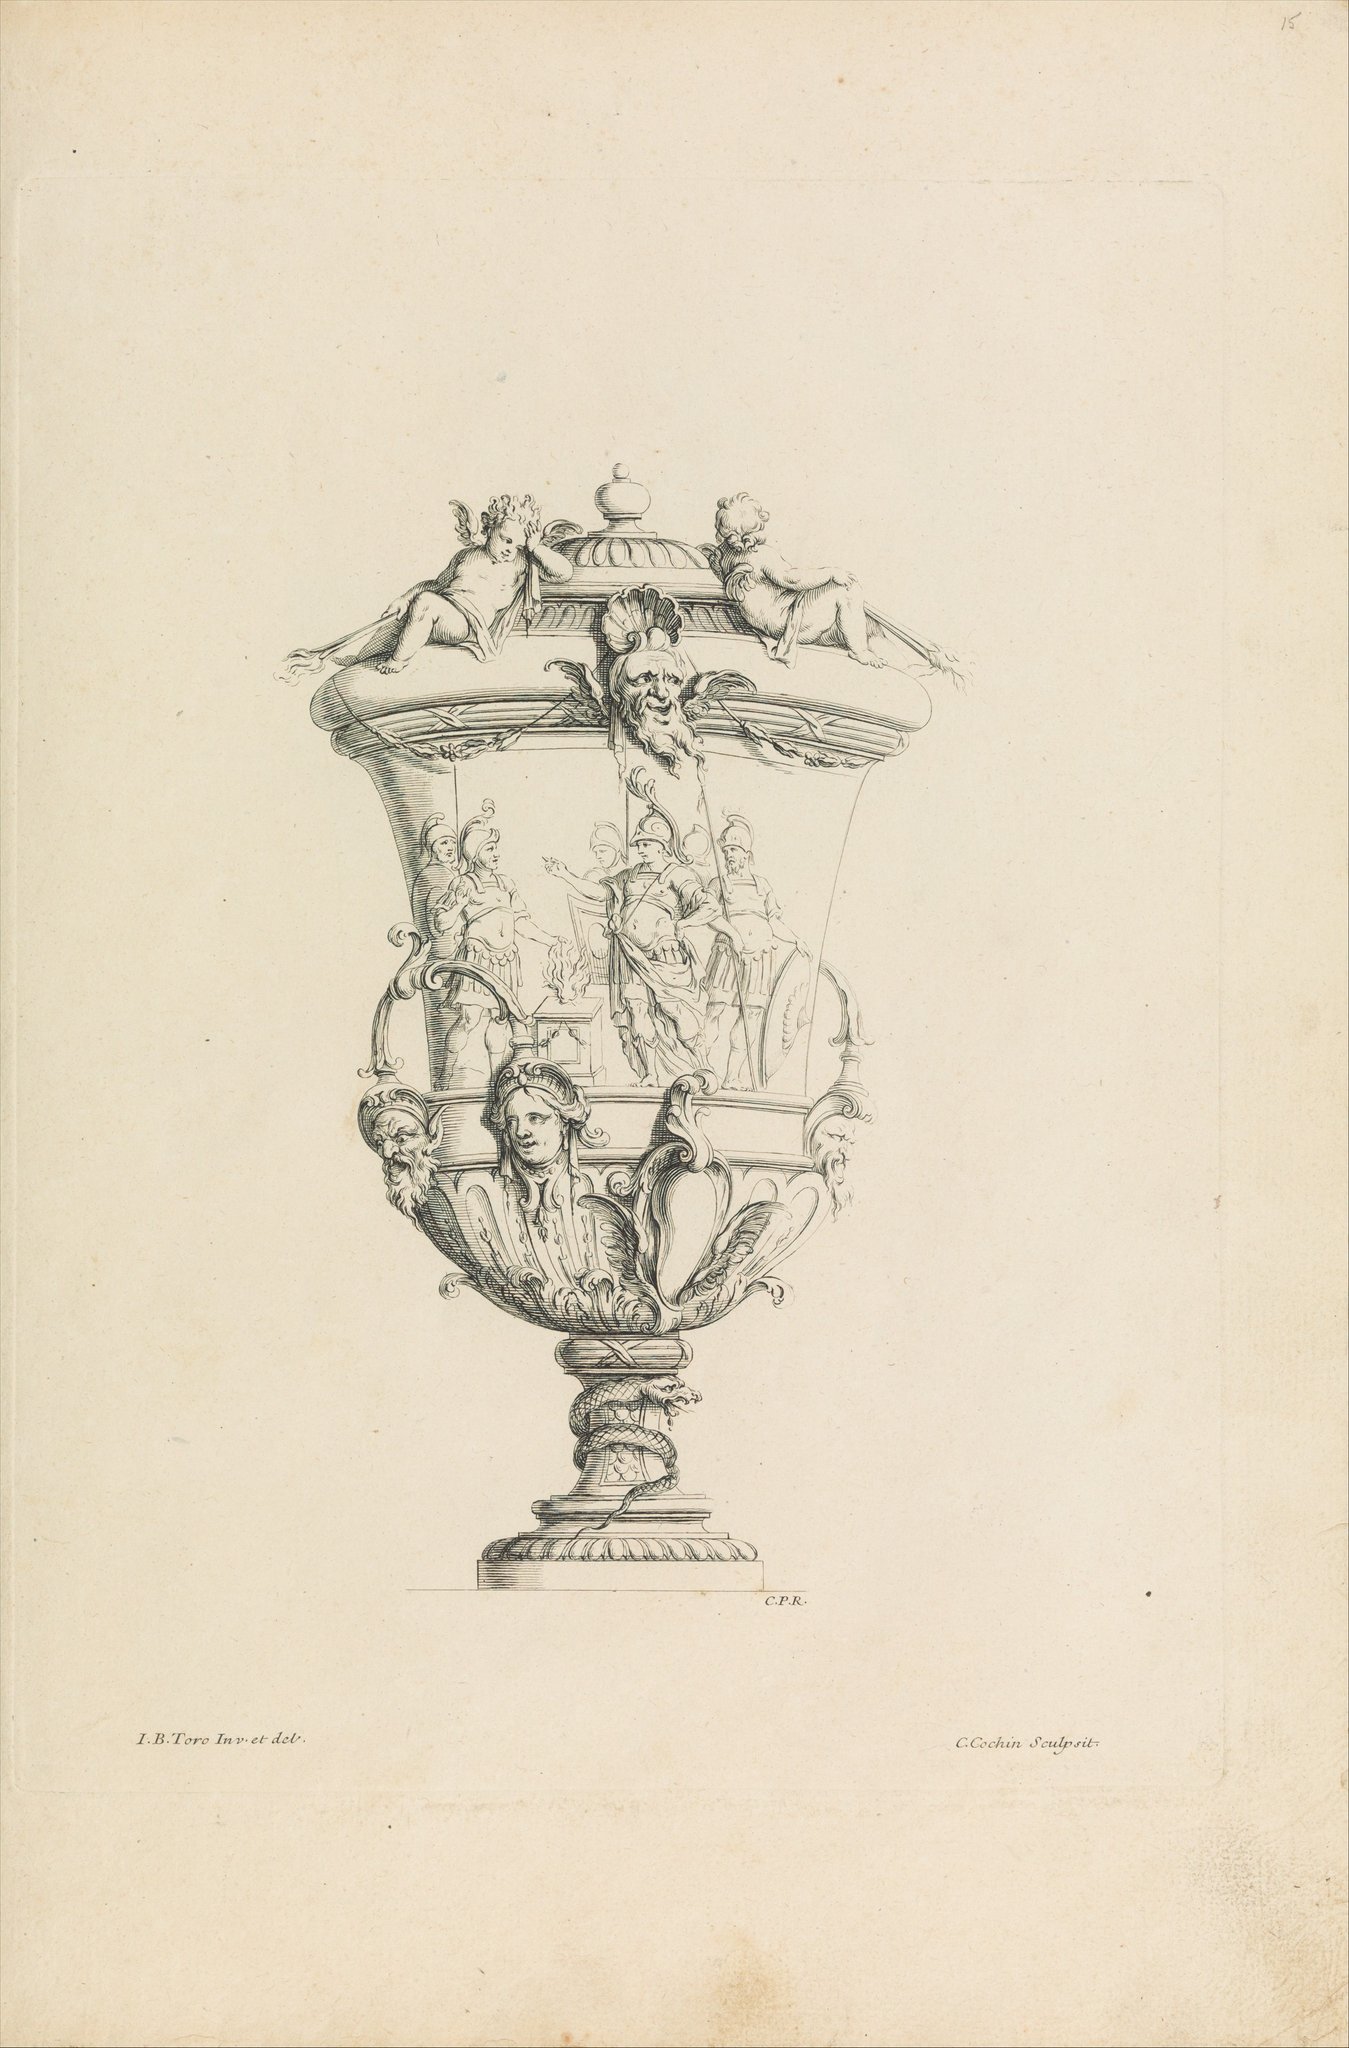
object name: album print ornament architecture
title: Nouveau Livre de Vases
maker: jean bernard toro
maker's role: designer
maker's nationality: french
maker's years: 1672-1731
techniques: etching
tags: men,putti,snakes,vases